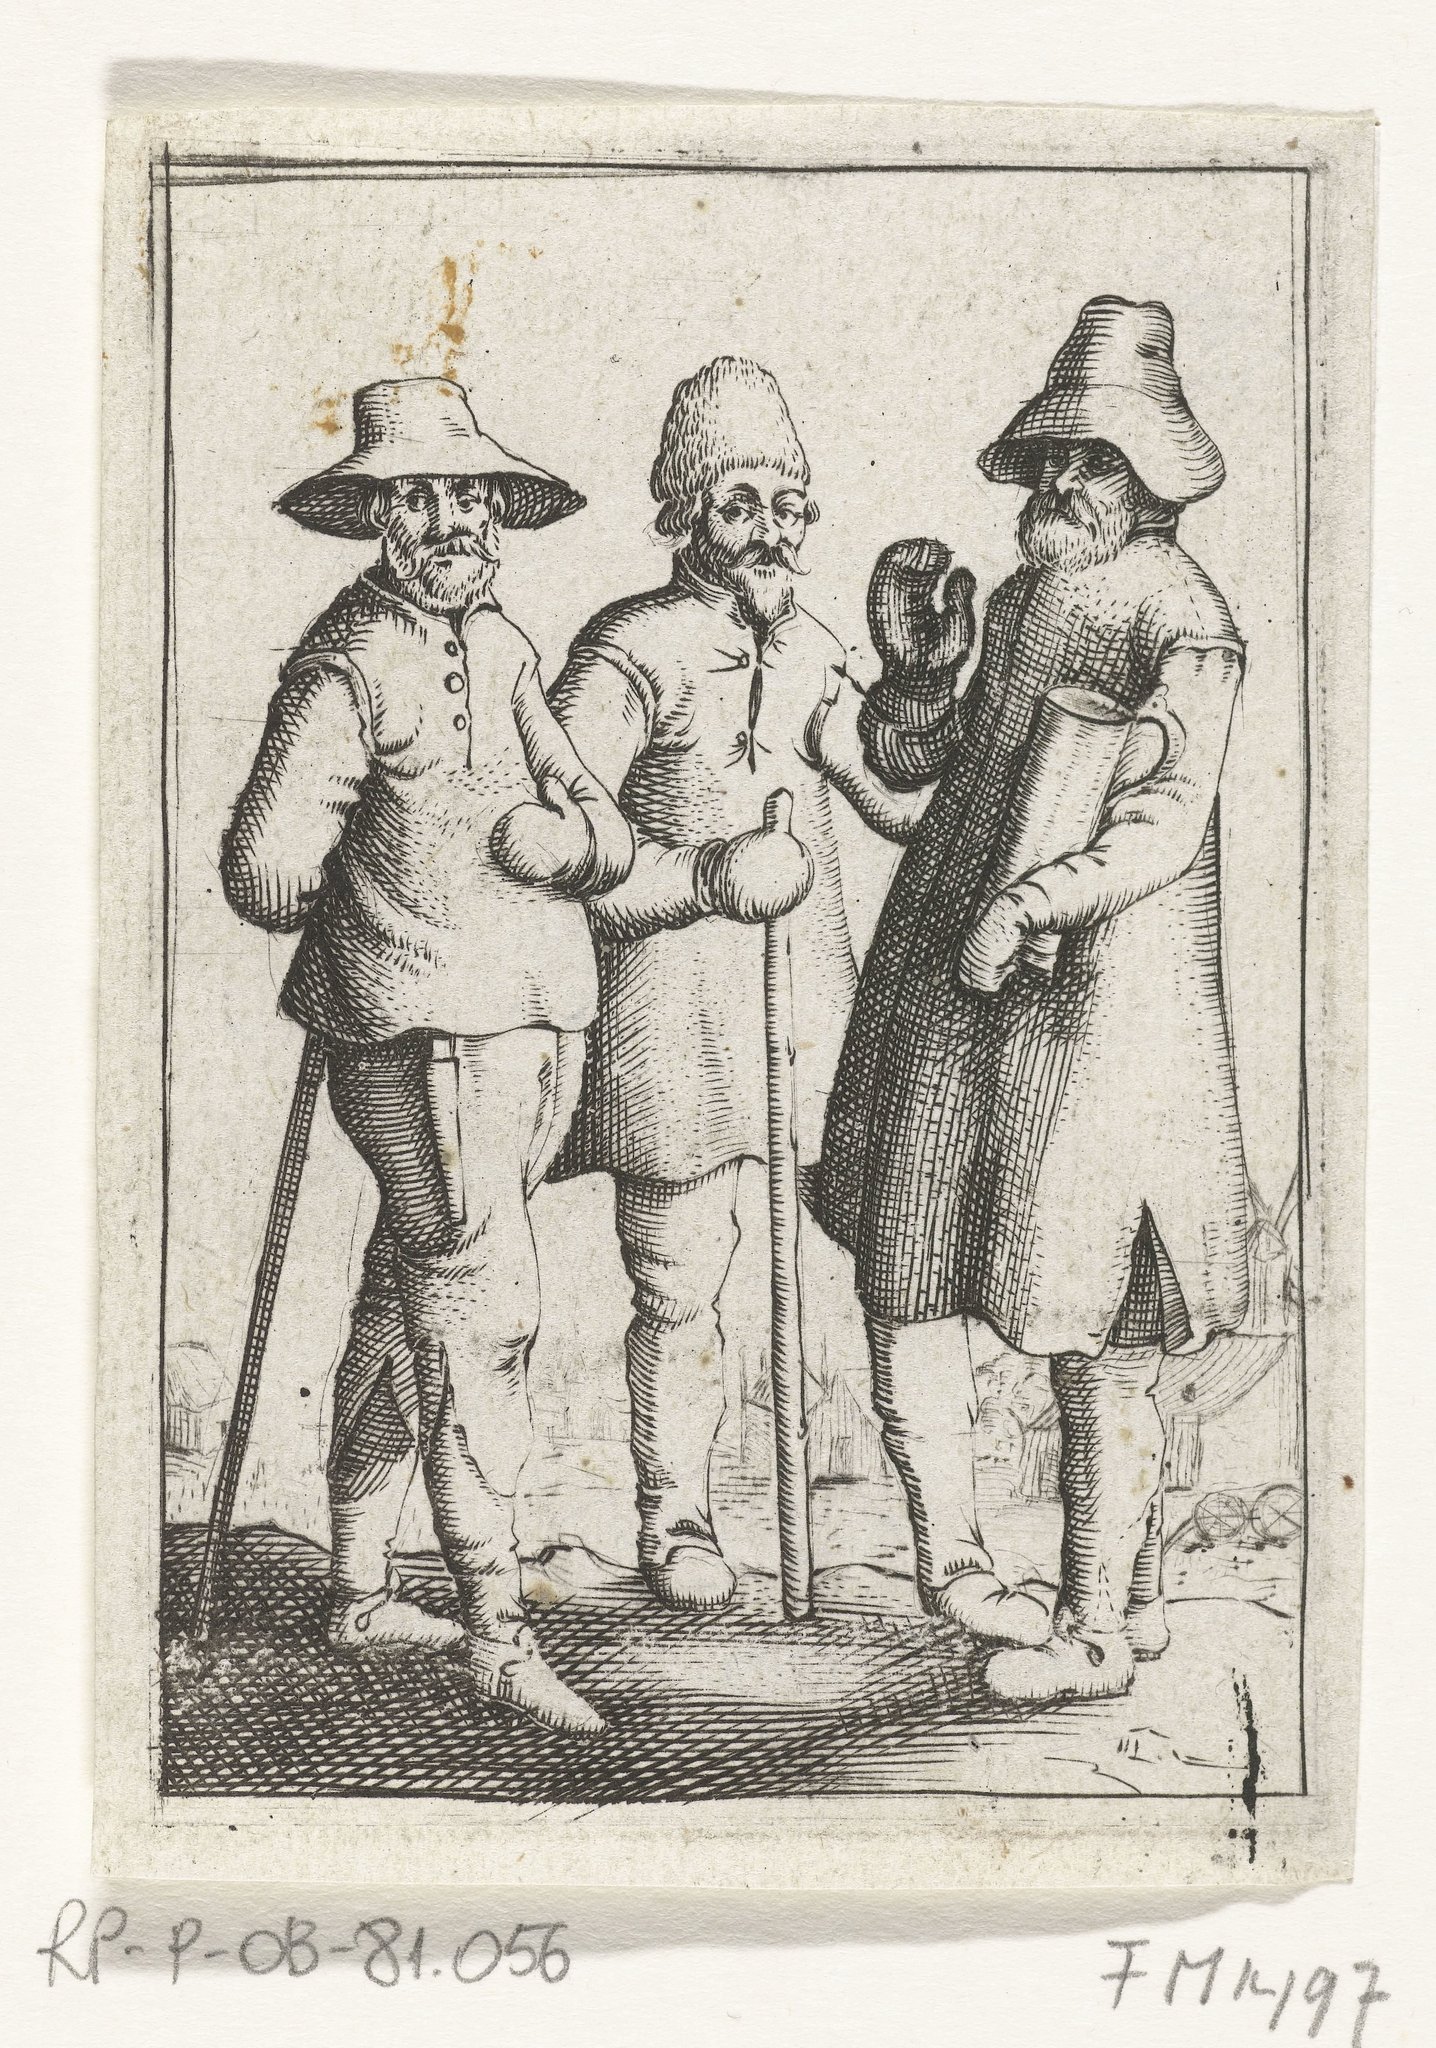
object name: print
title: Reinier van Oldenbarnevelt, Adriaan van Dijk en Henricus Slatius, 1623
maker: Anonymous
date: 1623-1649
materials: paper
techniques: engraving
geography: northern netherlands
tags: maurice (prince of orange), the hague, arrest (of criminal)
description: Reinier van Oldenbarnevelt, Adriaan van Dijk en Henricus Slatius, 1623. De drie samenzweerders tegen Maurits staande bij elkaar, twee met stokken in de hand, Slatius met de bierkan.